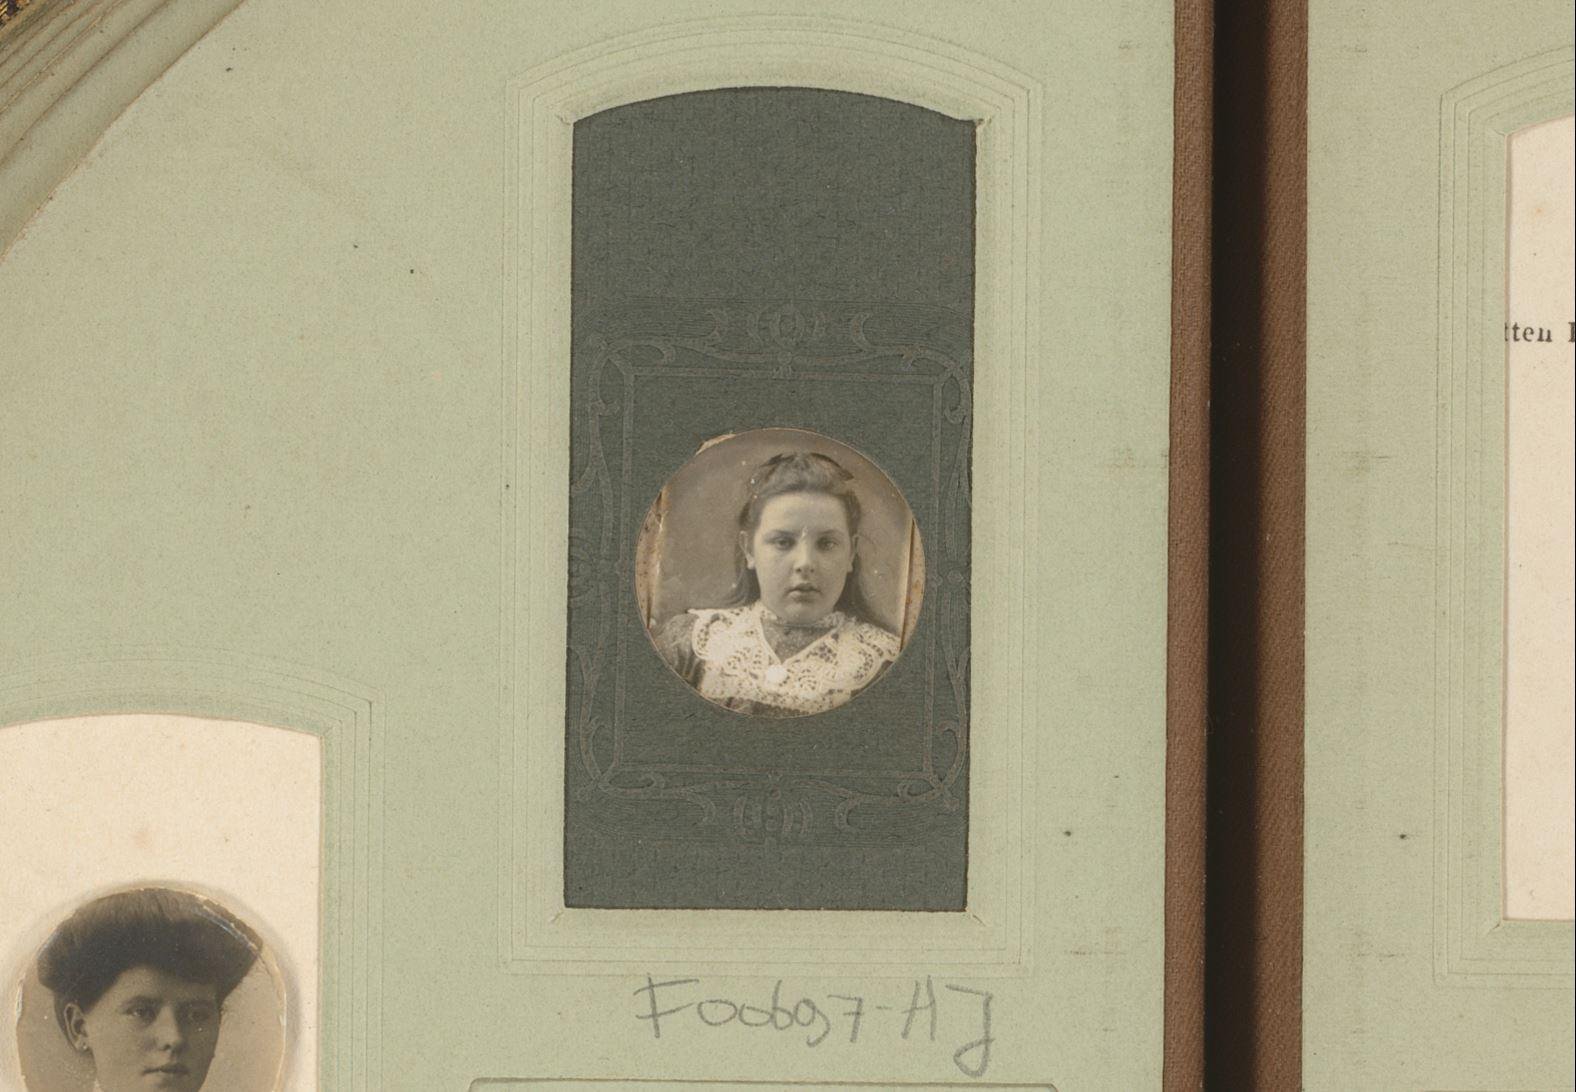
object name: album leaf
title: Portret van een meisje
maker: Anonymous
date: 1900-1915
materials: photographic support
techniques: gelatin silver print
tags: historical persons, girl (child between toddler and youth)